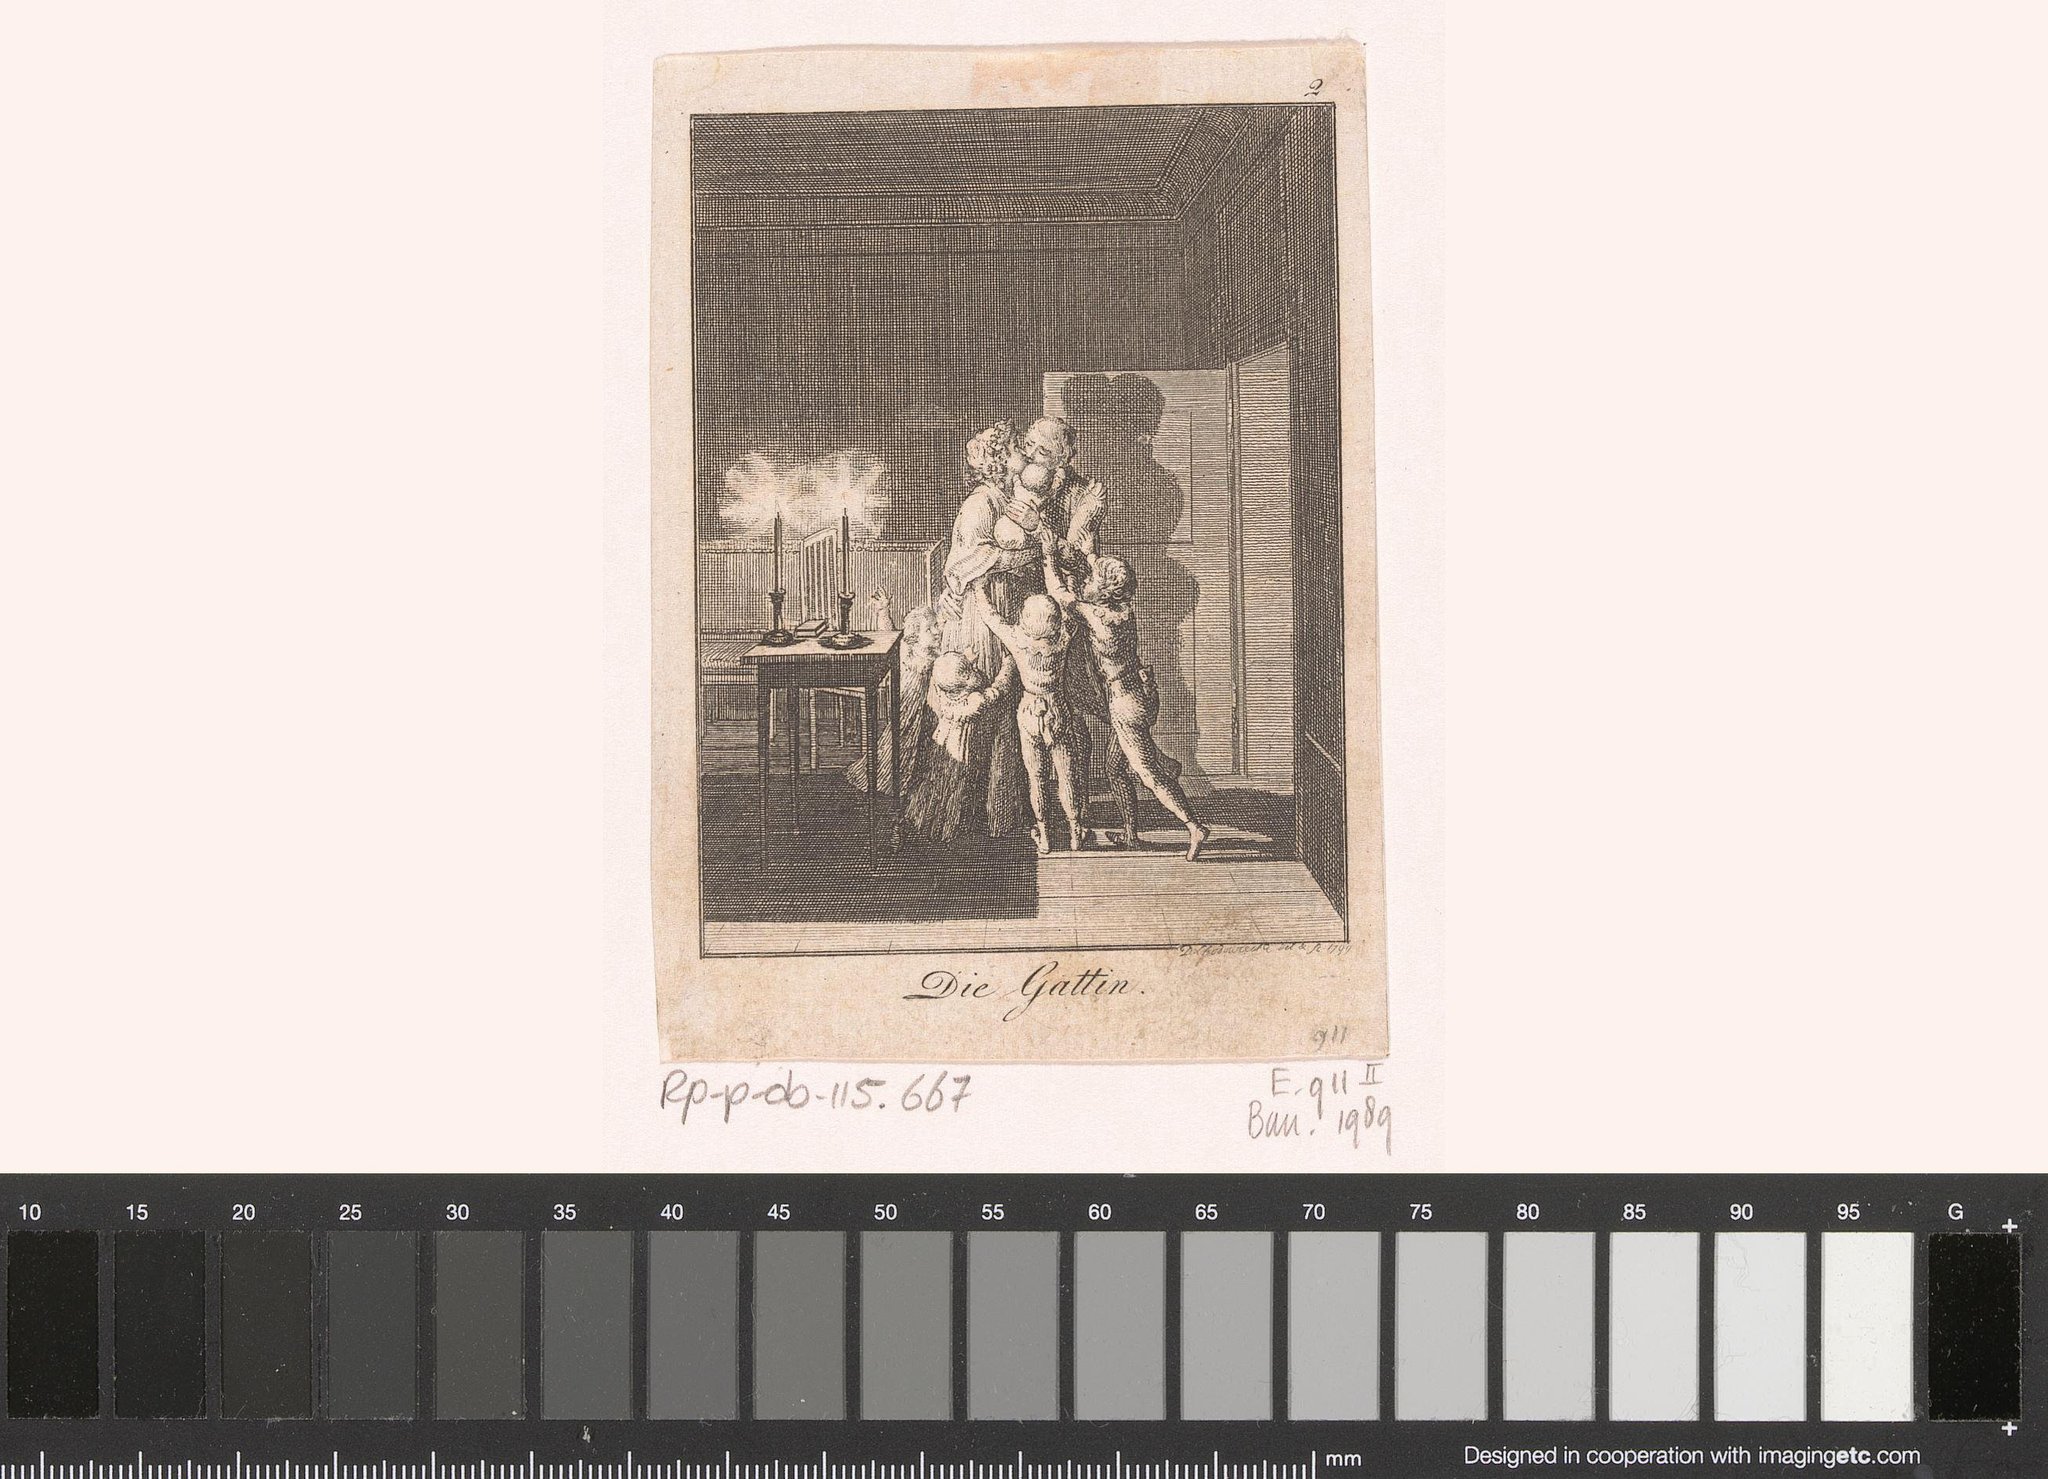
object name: print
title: Dame als echtgenote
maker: daniel nikolaus chodowiecki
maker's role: draughtsman, print maker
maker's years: 1726-1801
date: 1799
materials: paper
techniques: etching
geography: berlin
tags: mother with son(s) and daughter(s) (mother-love)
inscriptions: collector's mark: Lugt 2228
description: Prent gebruikt voor: Neuffer, Christian Ludwig. Taschenbuch für Frauenzimmer von Bildung auf das Jahr 1800 (...). Stuttgart: Steinkopf, s.a.